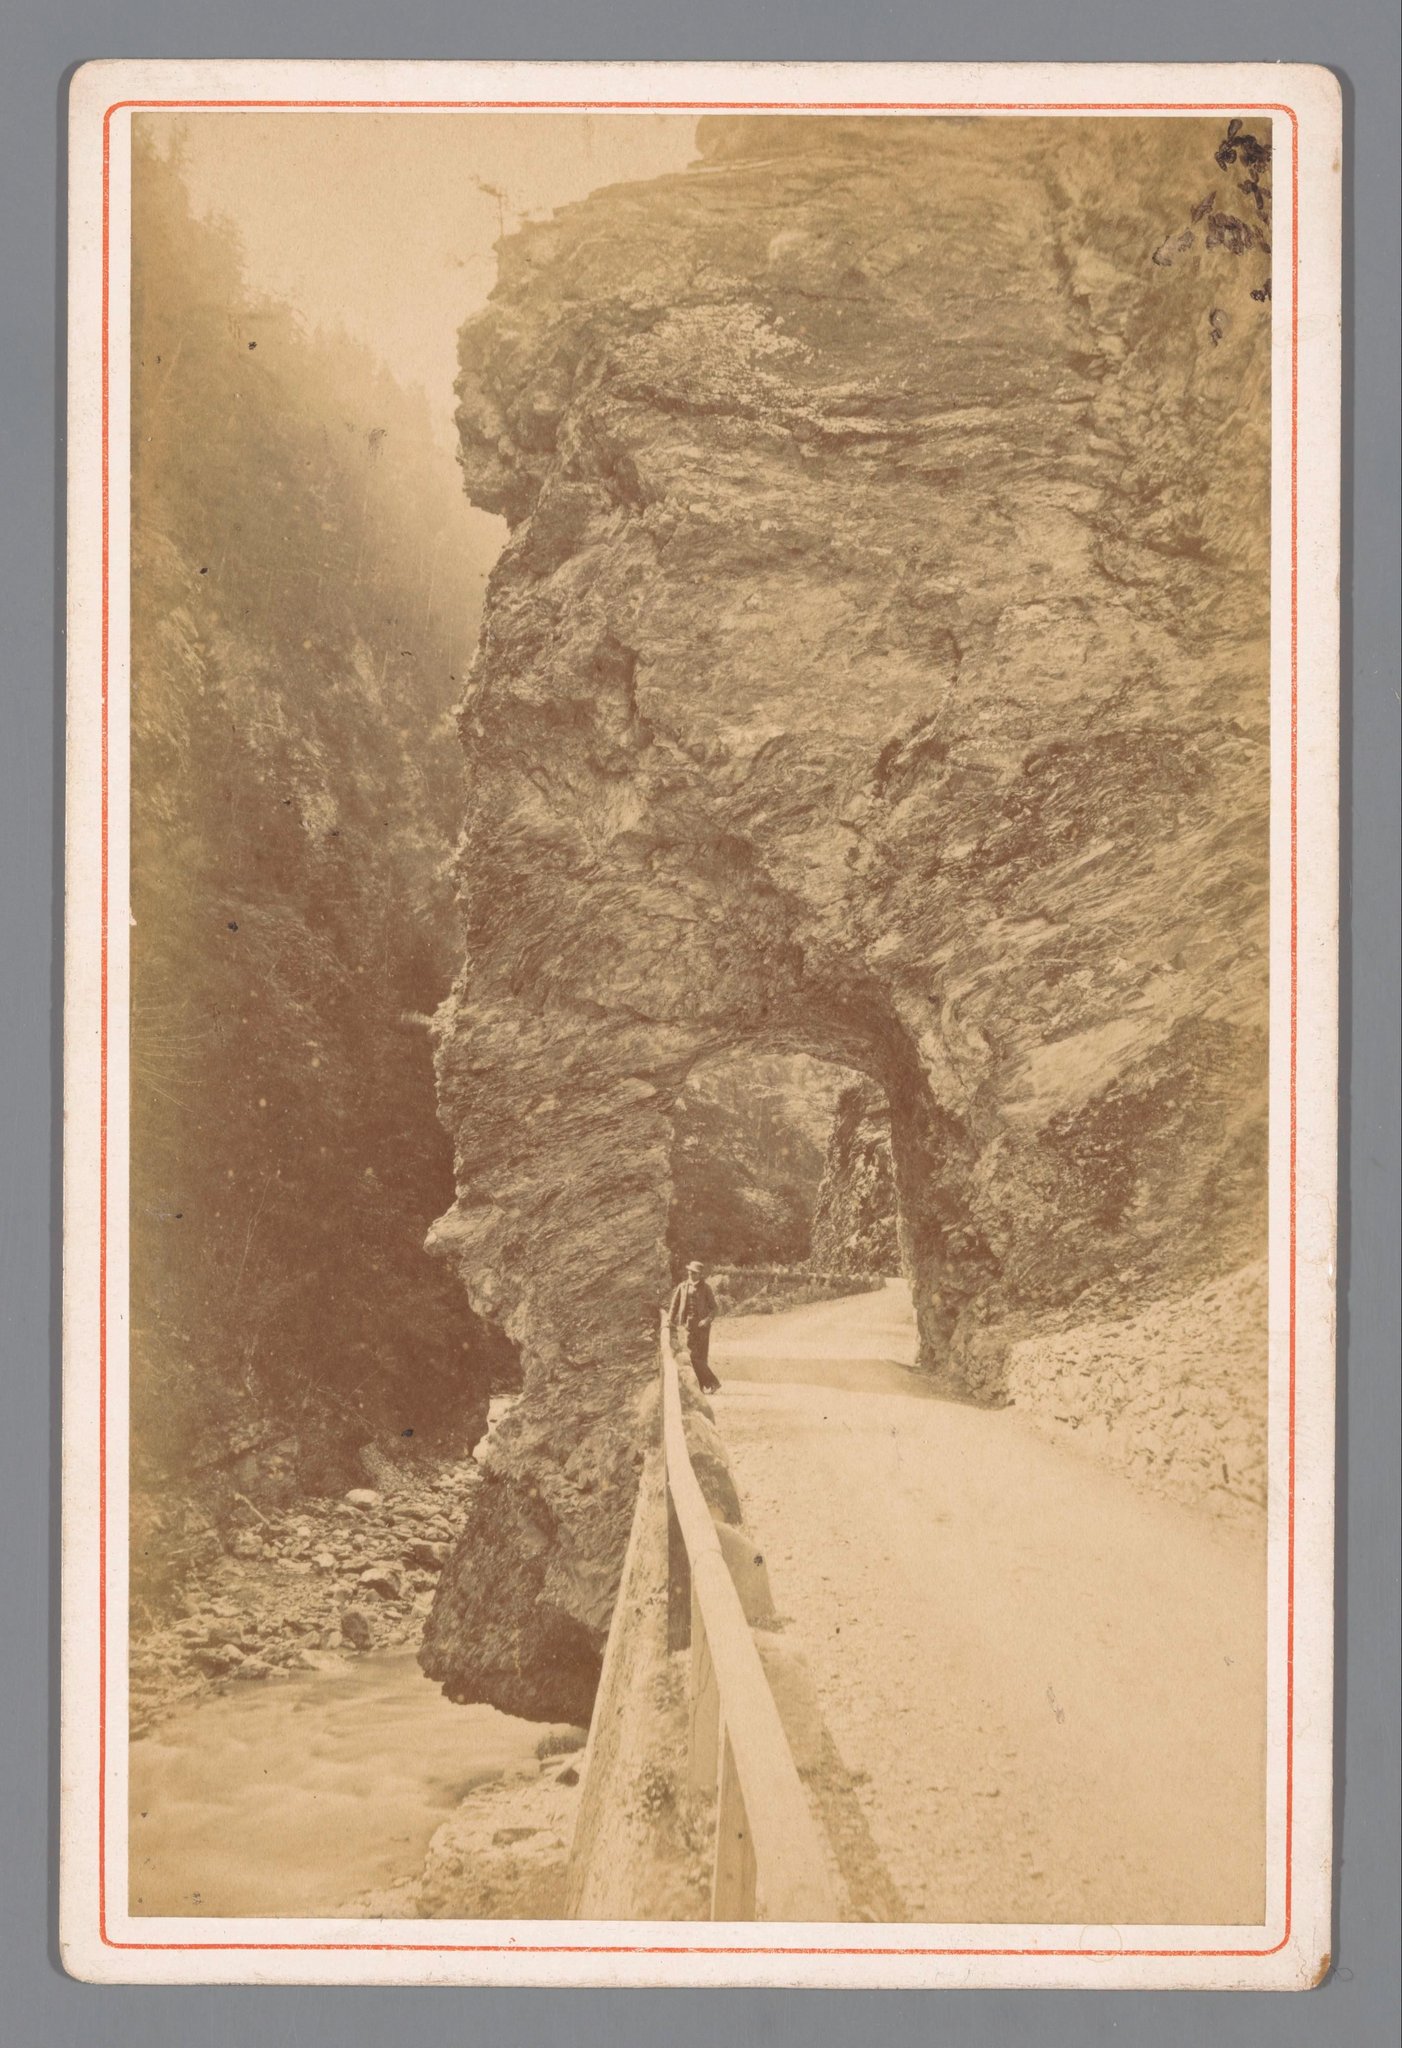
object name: photograph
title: Rocher percé dans la Tamina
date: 1860-1877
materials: cardboard, photographic support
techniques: albumen print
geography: taminakloof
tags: ravine, chasm, abyss, canyon, road, path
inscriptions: number: ‘No 586’